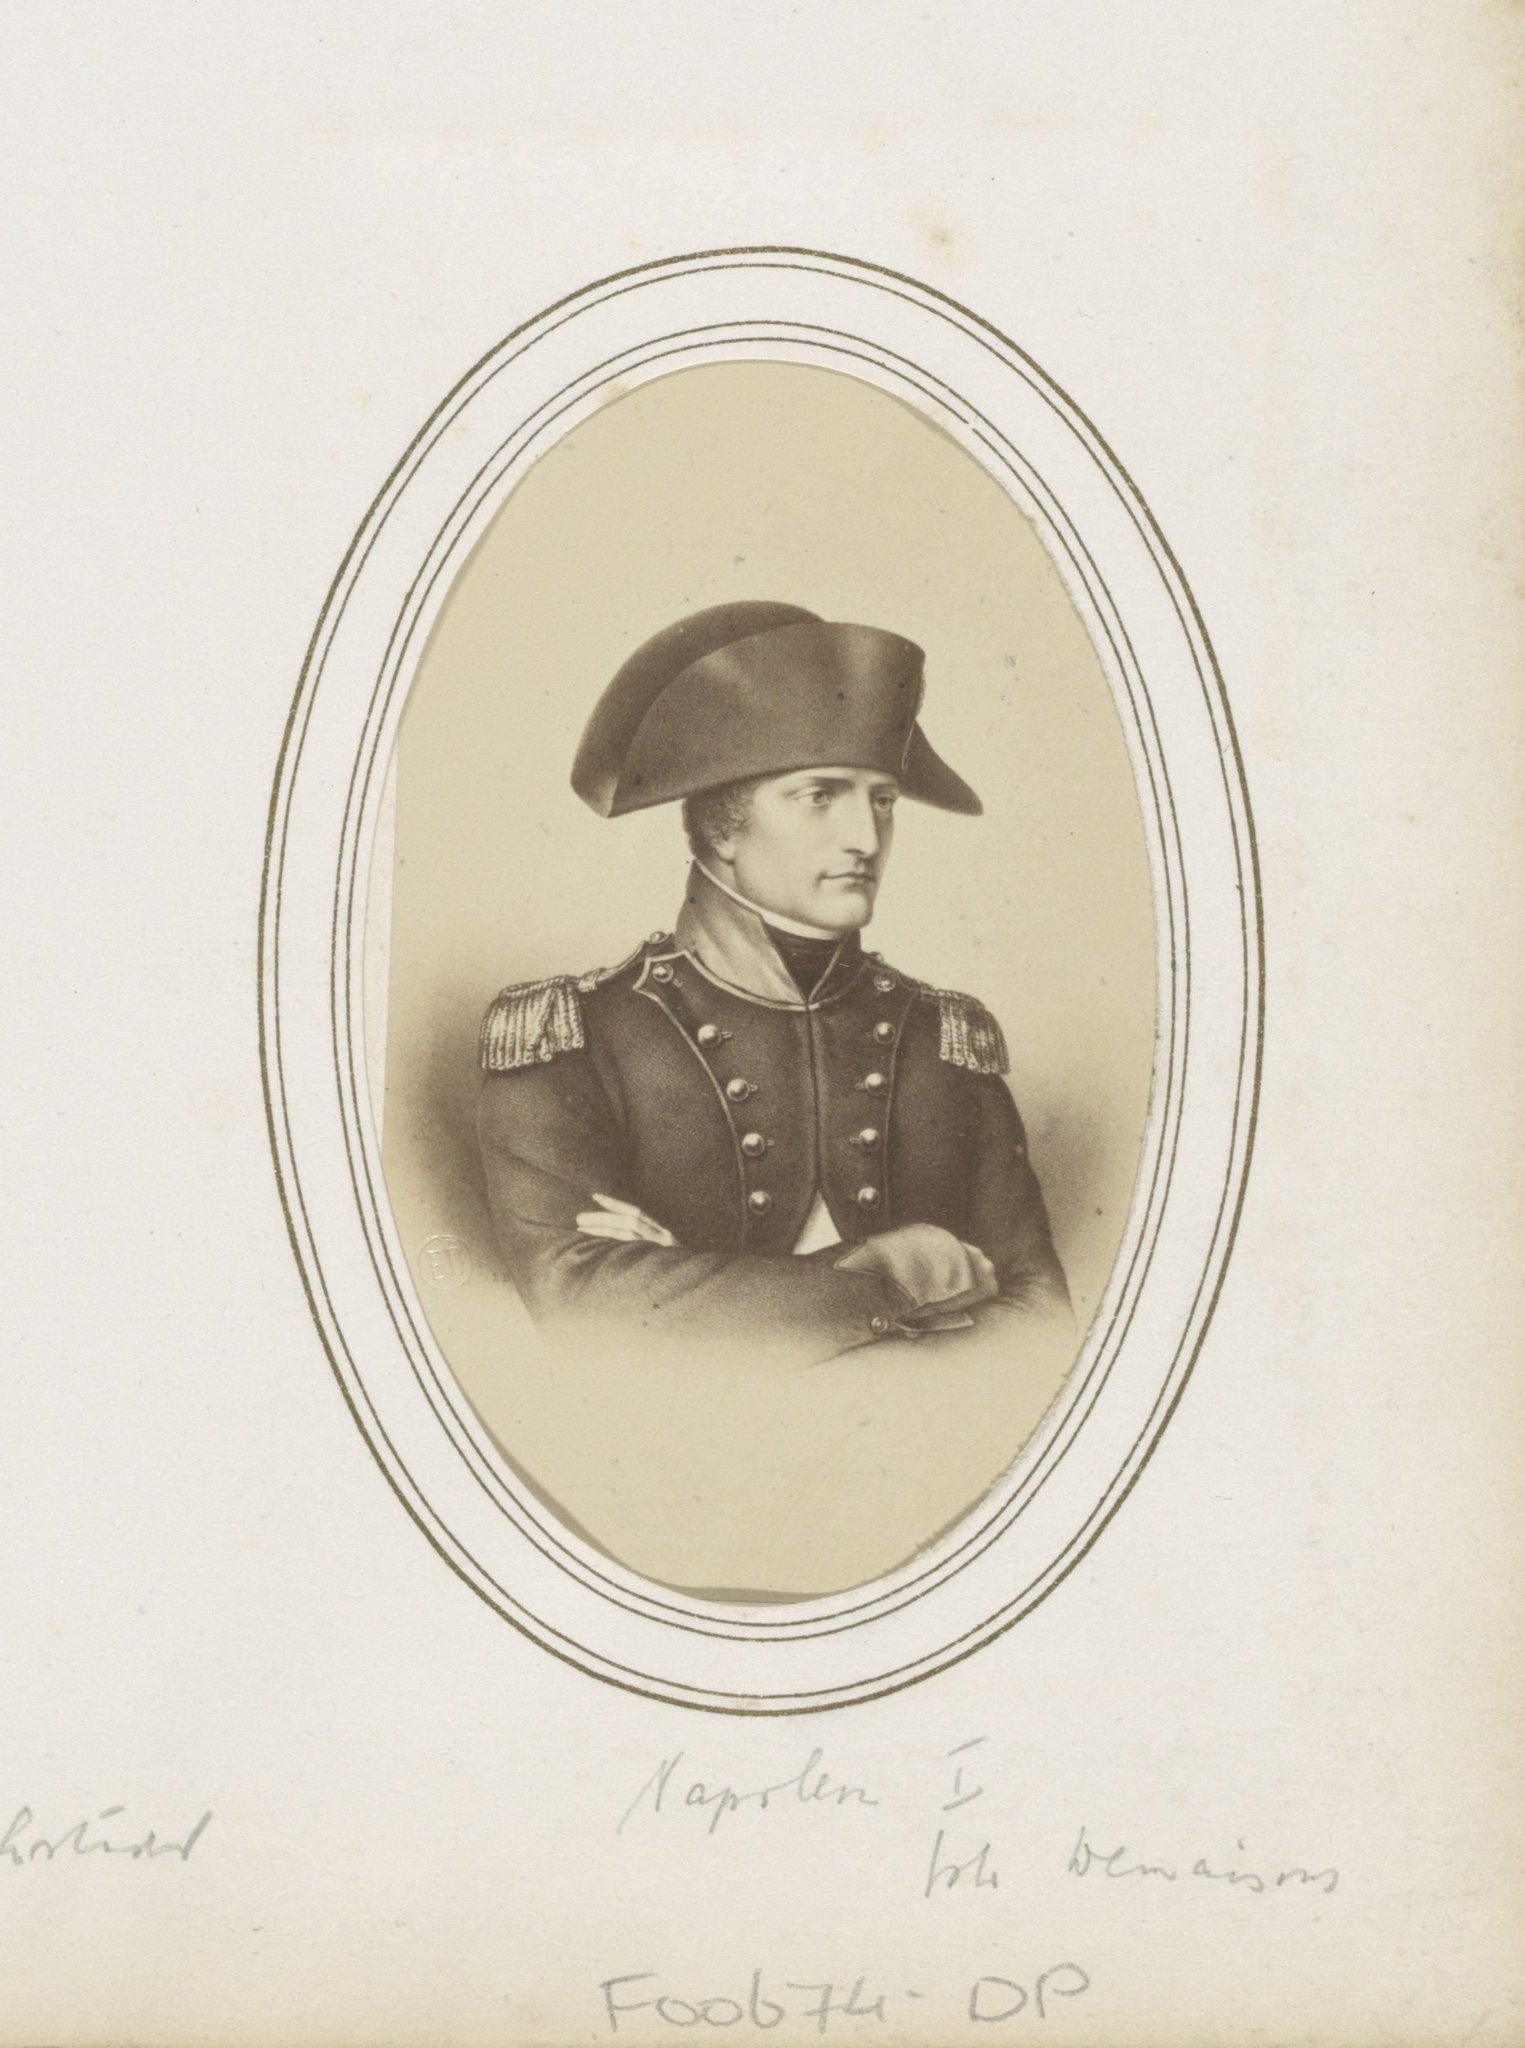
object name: photograph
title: Fotoreproductie van (vermoedelijk) een prent van Napoleon I Bonaparte, keizer van Frankrijk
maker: émilien desmaisons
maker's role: draughtsman, print maker, publisher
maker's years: 1812-1880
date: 1855-1870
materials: cardboard, paper, photographic support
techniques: albumen print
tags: napoleon i (emperor of the french), historical persons, ruler, sovereign, (military) uniforms, arms crossed over the breast, head-gear: bicorne, bicorn (+ men's clothes)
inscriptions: inscription: ‘Bonaparte’, address: ‘5. Rue des Grandes Augustins Paris’, check stamp: ‘ED’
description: Onderdeel van Fotoalbum met 123 cartes-de-visite van leden van Europese vorstenhuizen, politici en bekende personen.